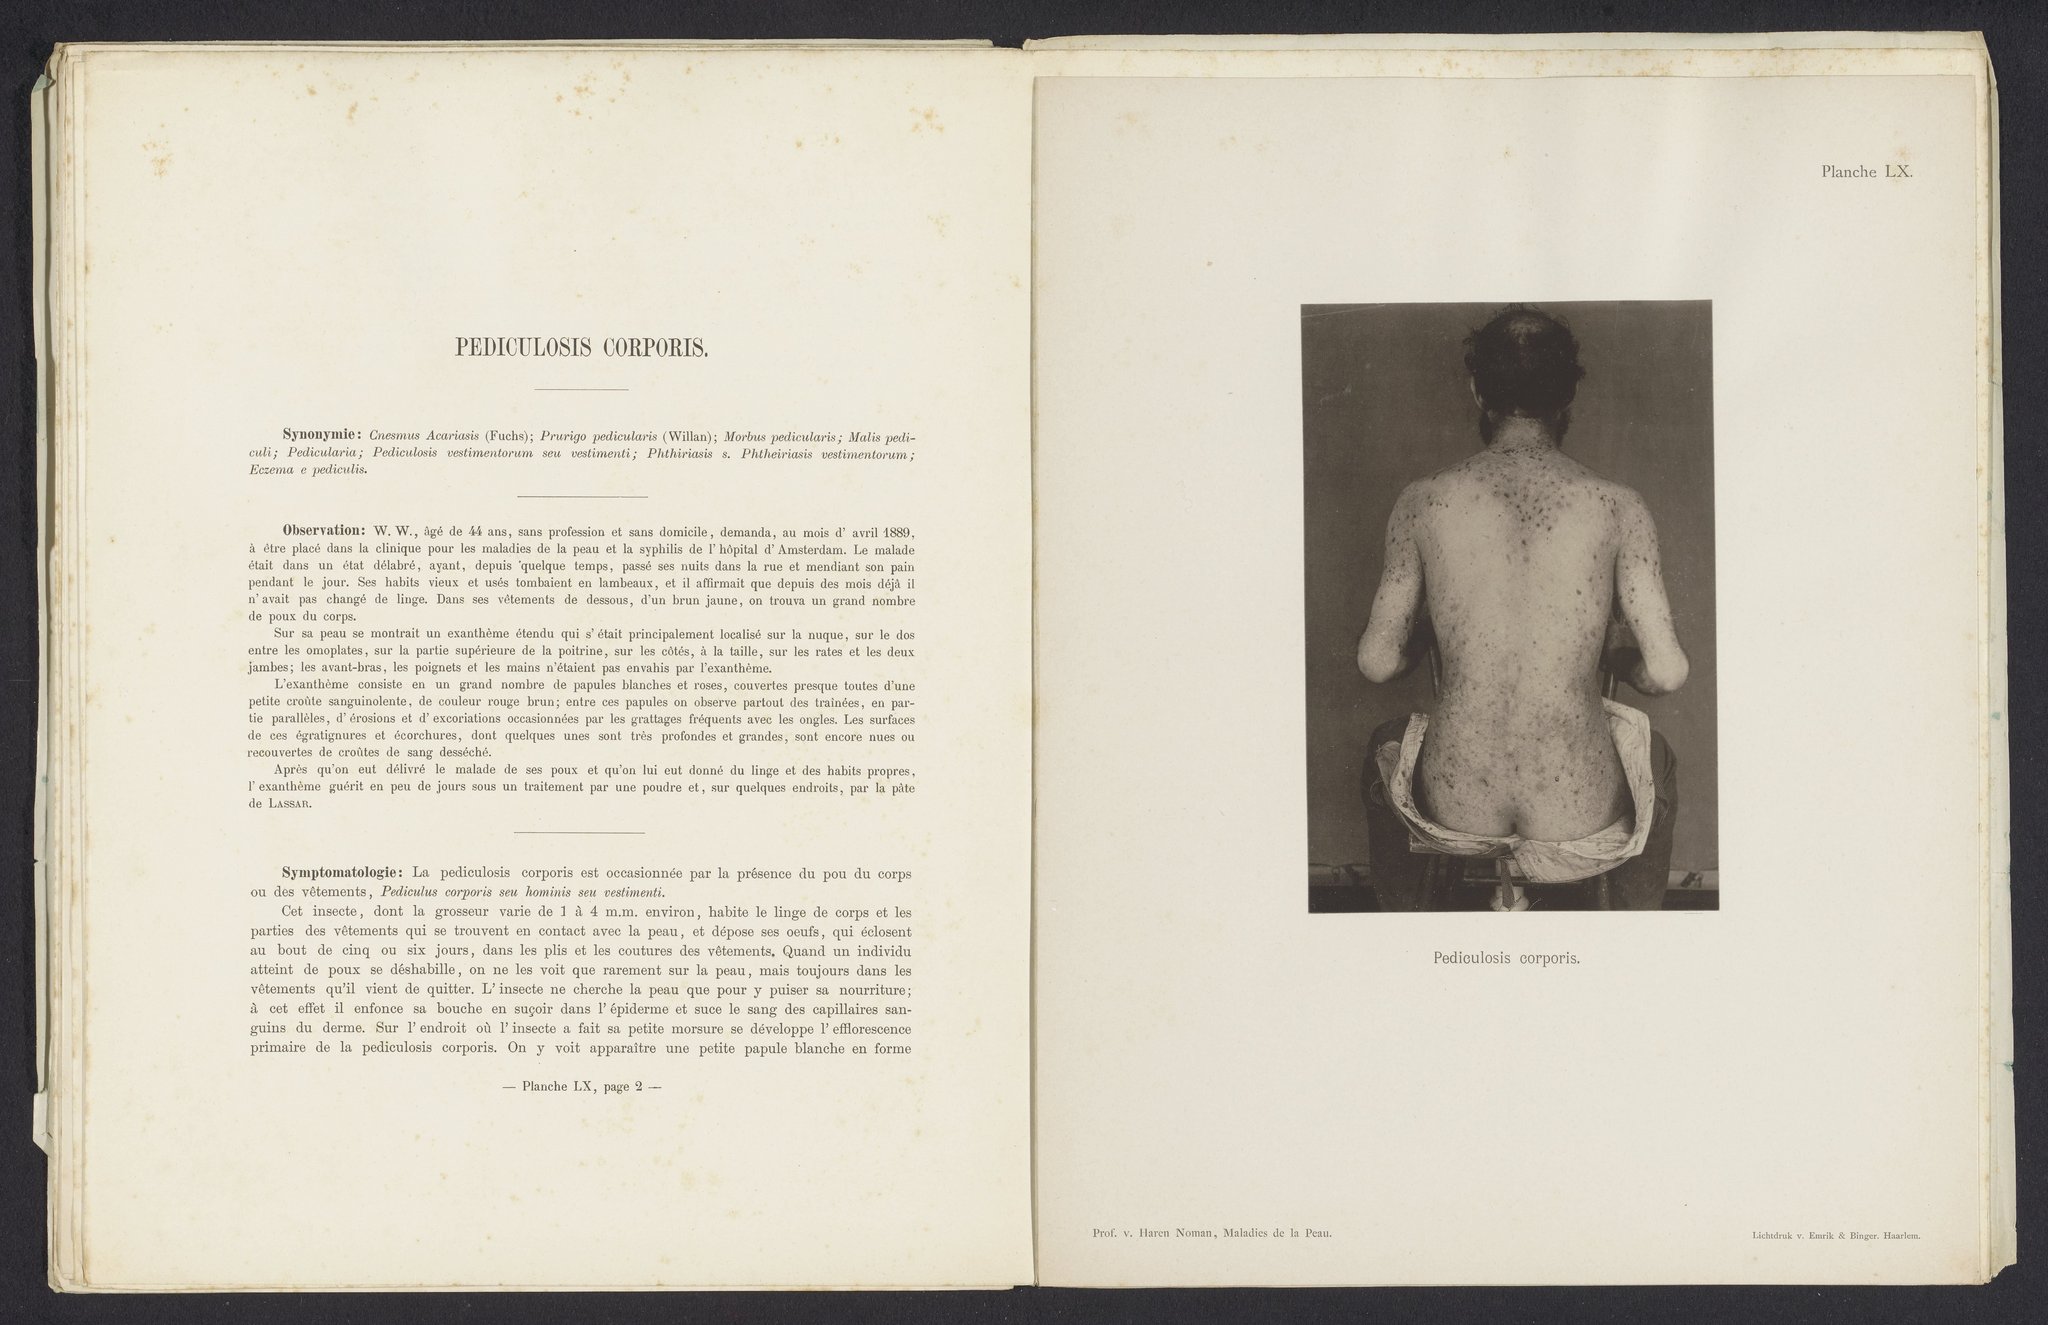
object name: photomechanical print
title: Pediculosis corporis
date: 1882-1892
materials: paper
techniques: photograph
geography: amsterdam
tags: skin and venereal diseases, adult man, back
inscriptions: number: ‘Planche LX.’